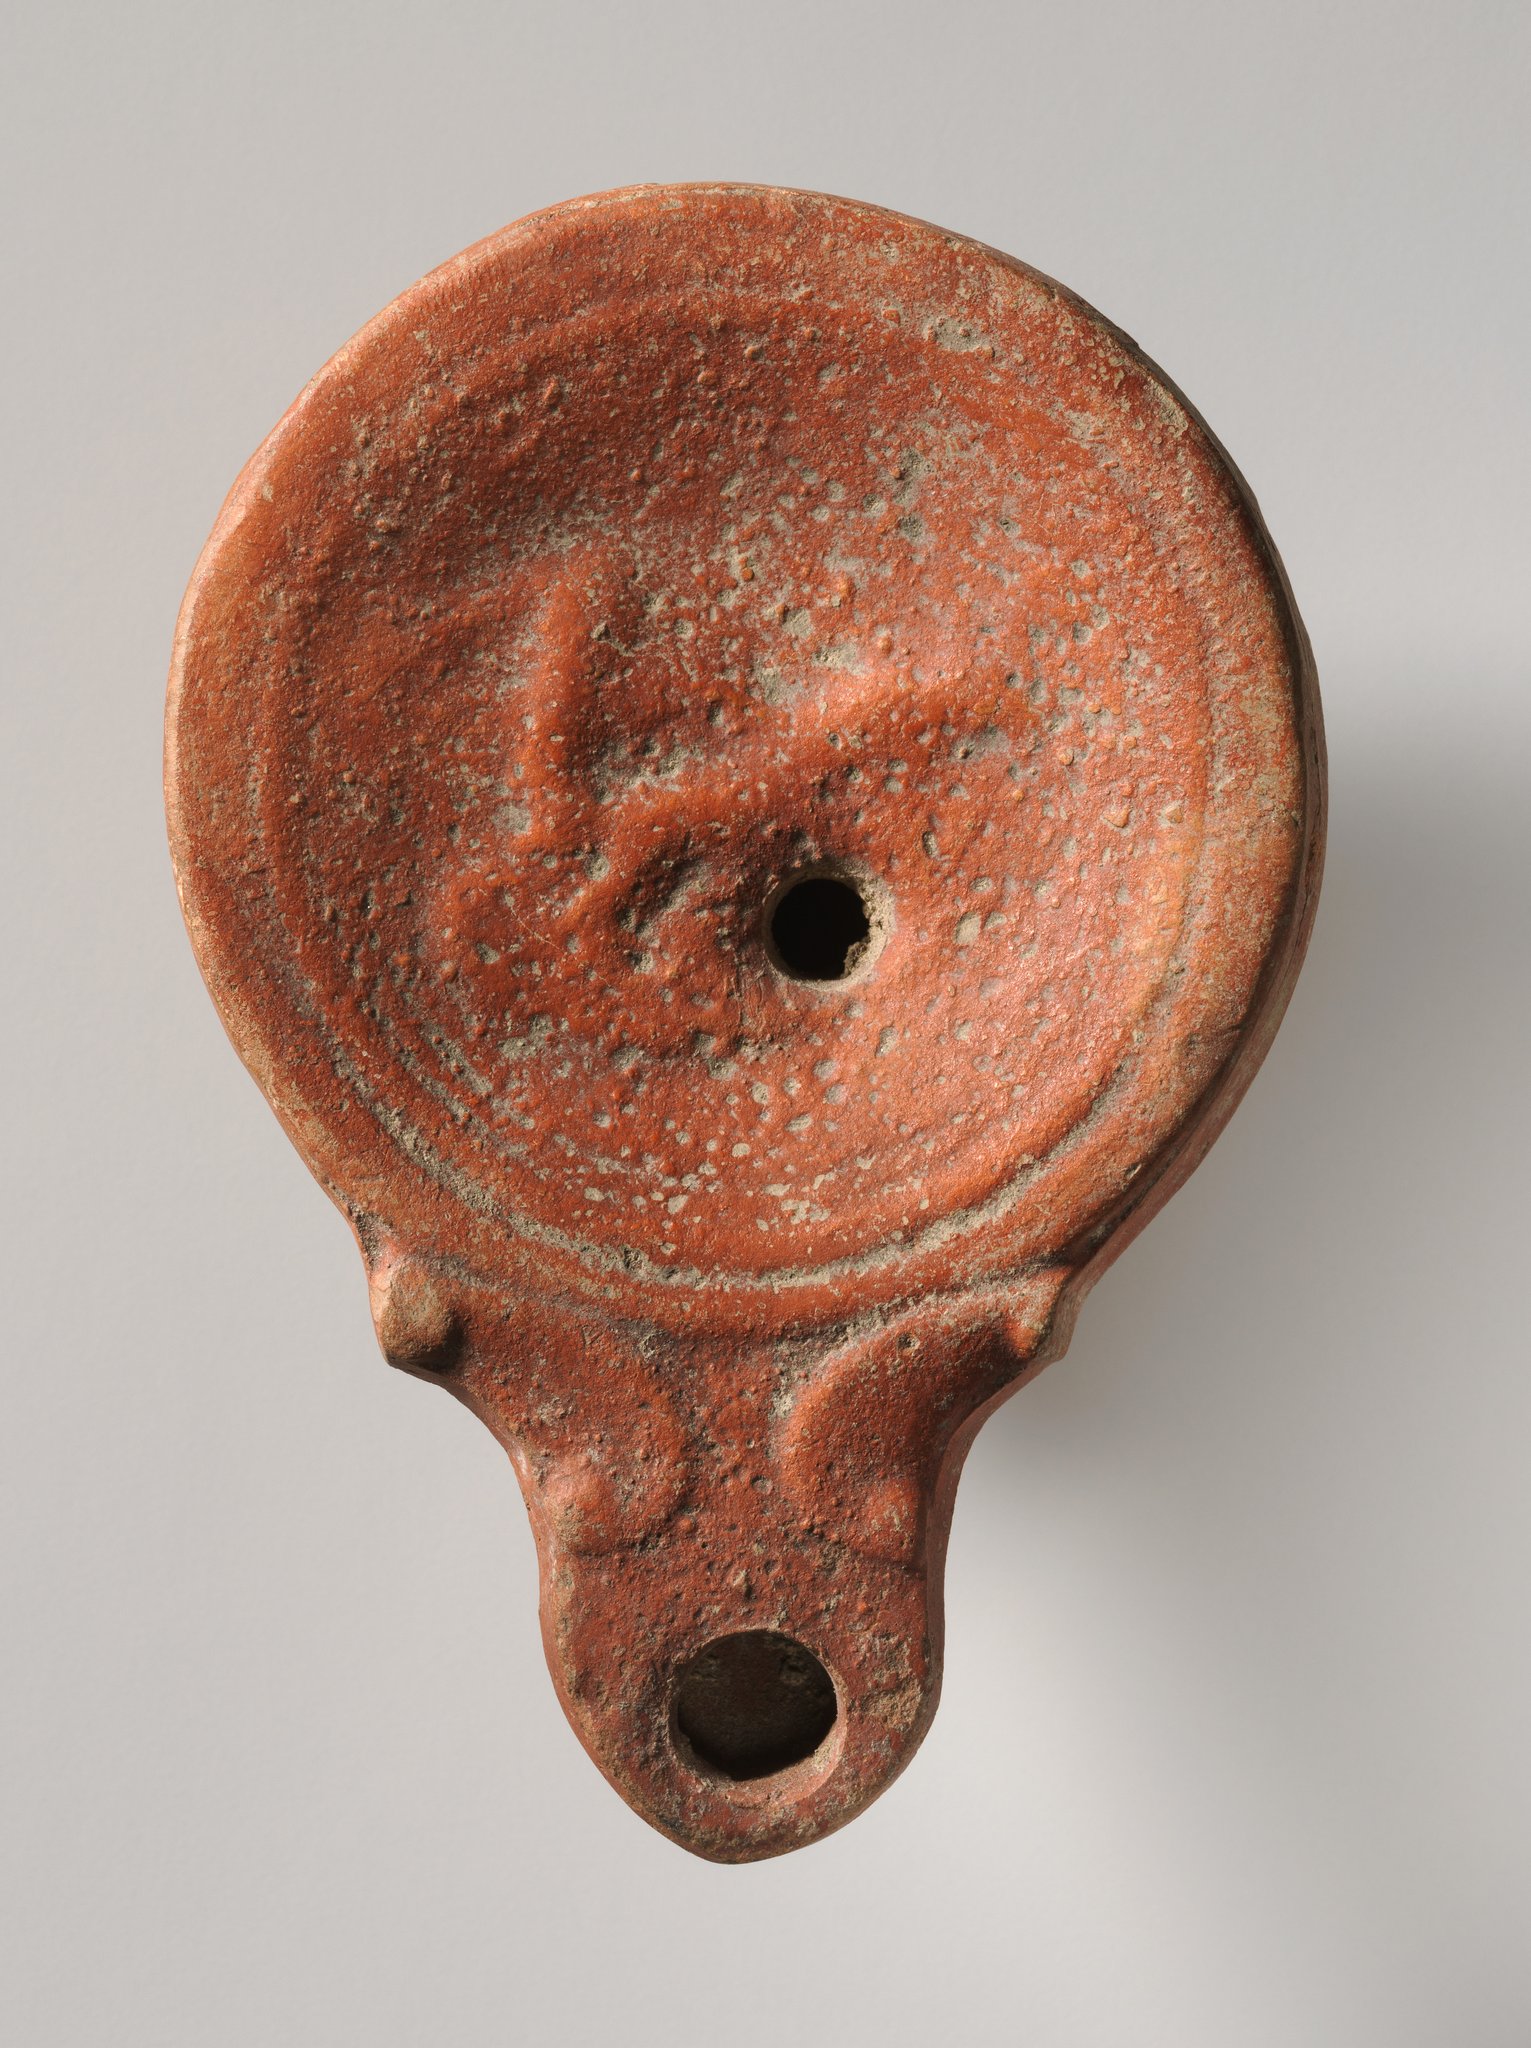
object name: lamp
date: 100 BCE-100 CE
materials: earthenware